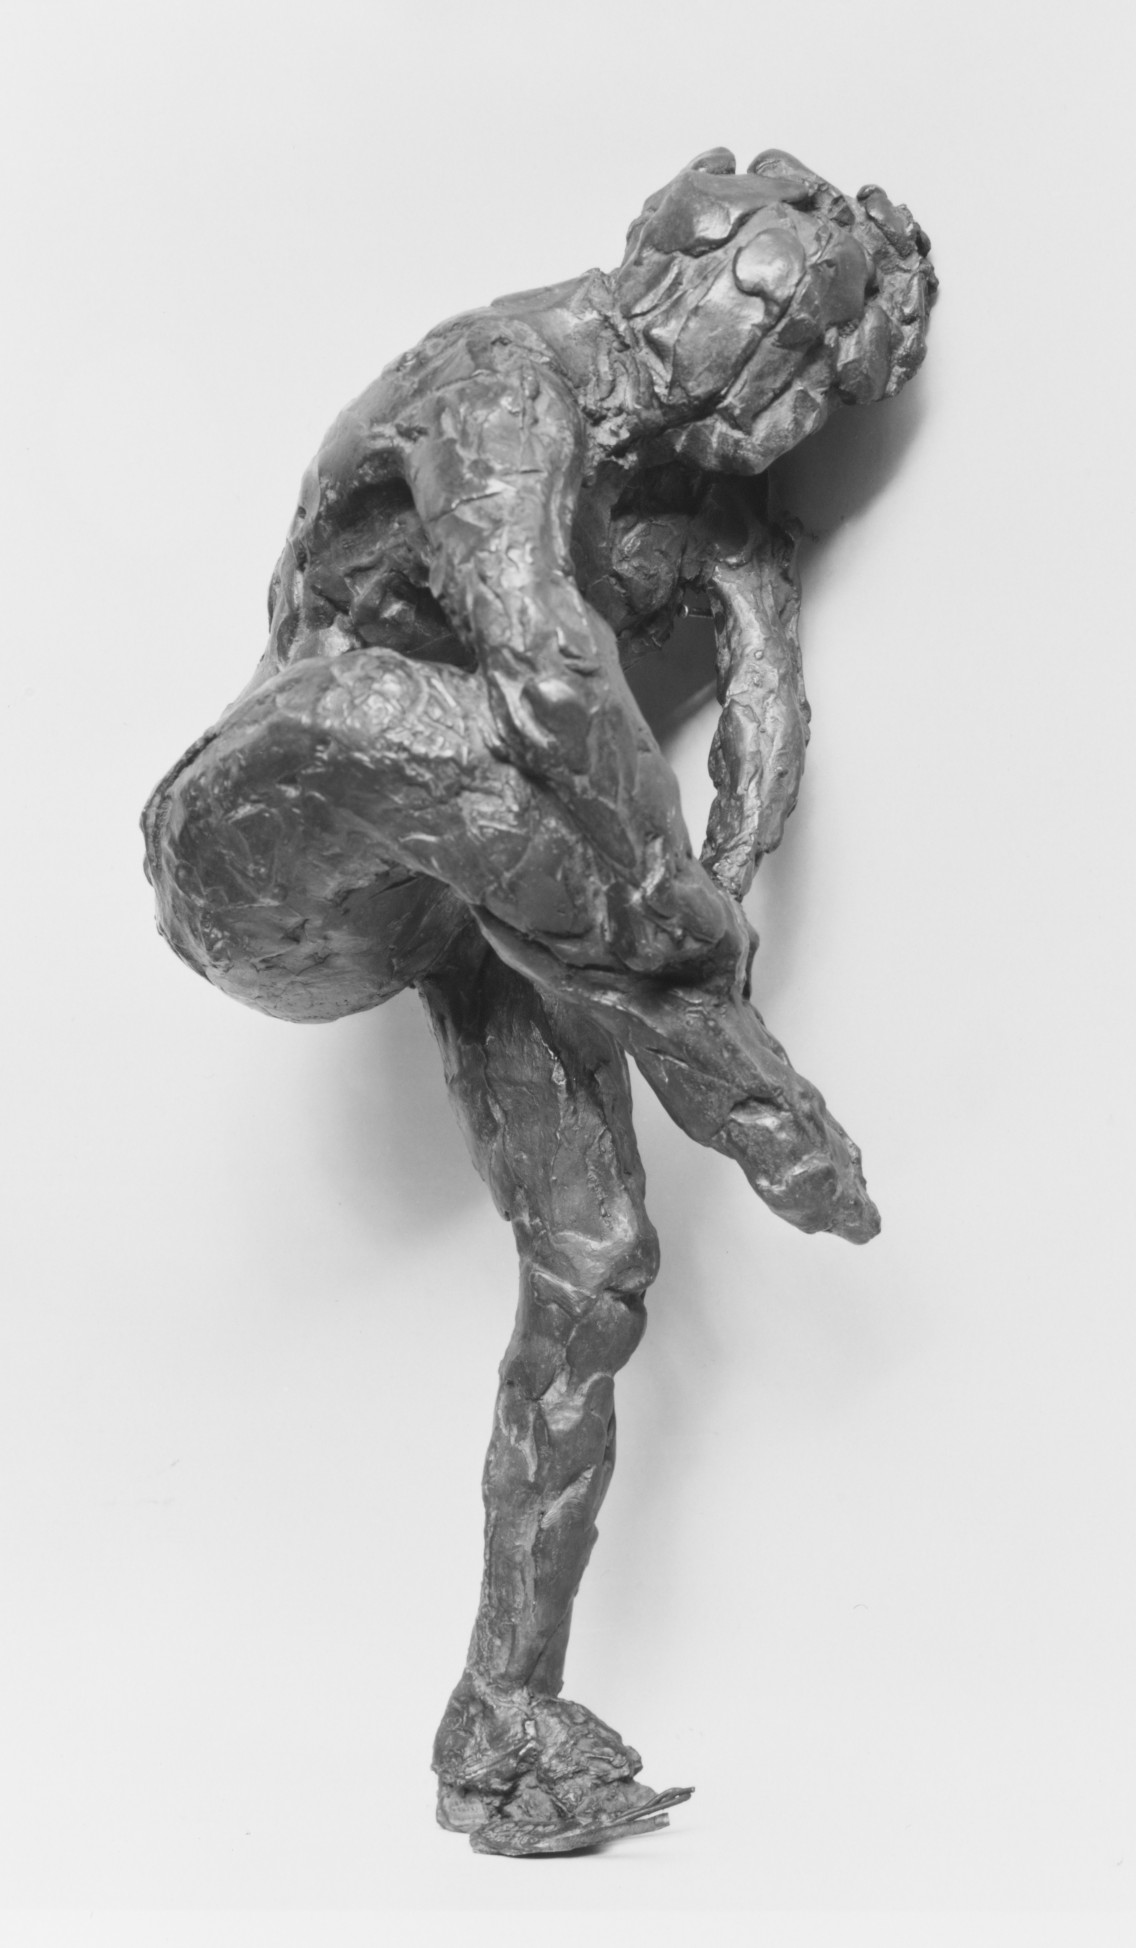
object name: statuette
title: Dancer Putting on Her Stocking (First State)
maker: edgar degas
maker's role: artist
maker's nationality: french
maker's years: 1834-1917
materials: bronze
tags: women,dancers